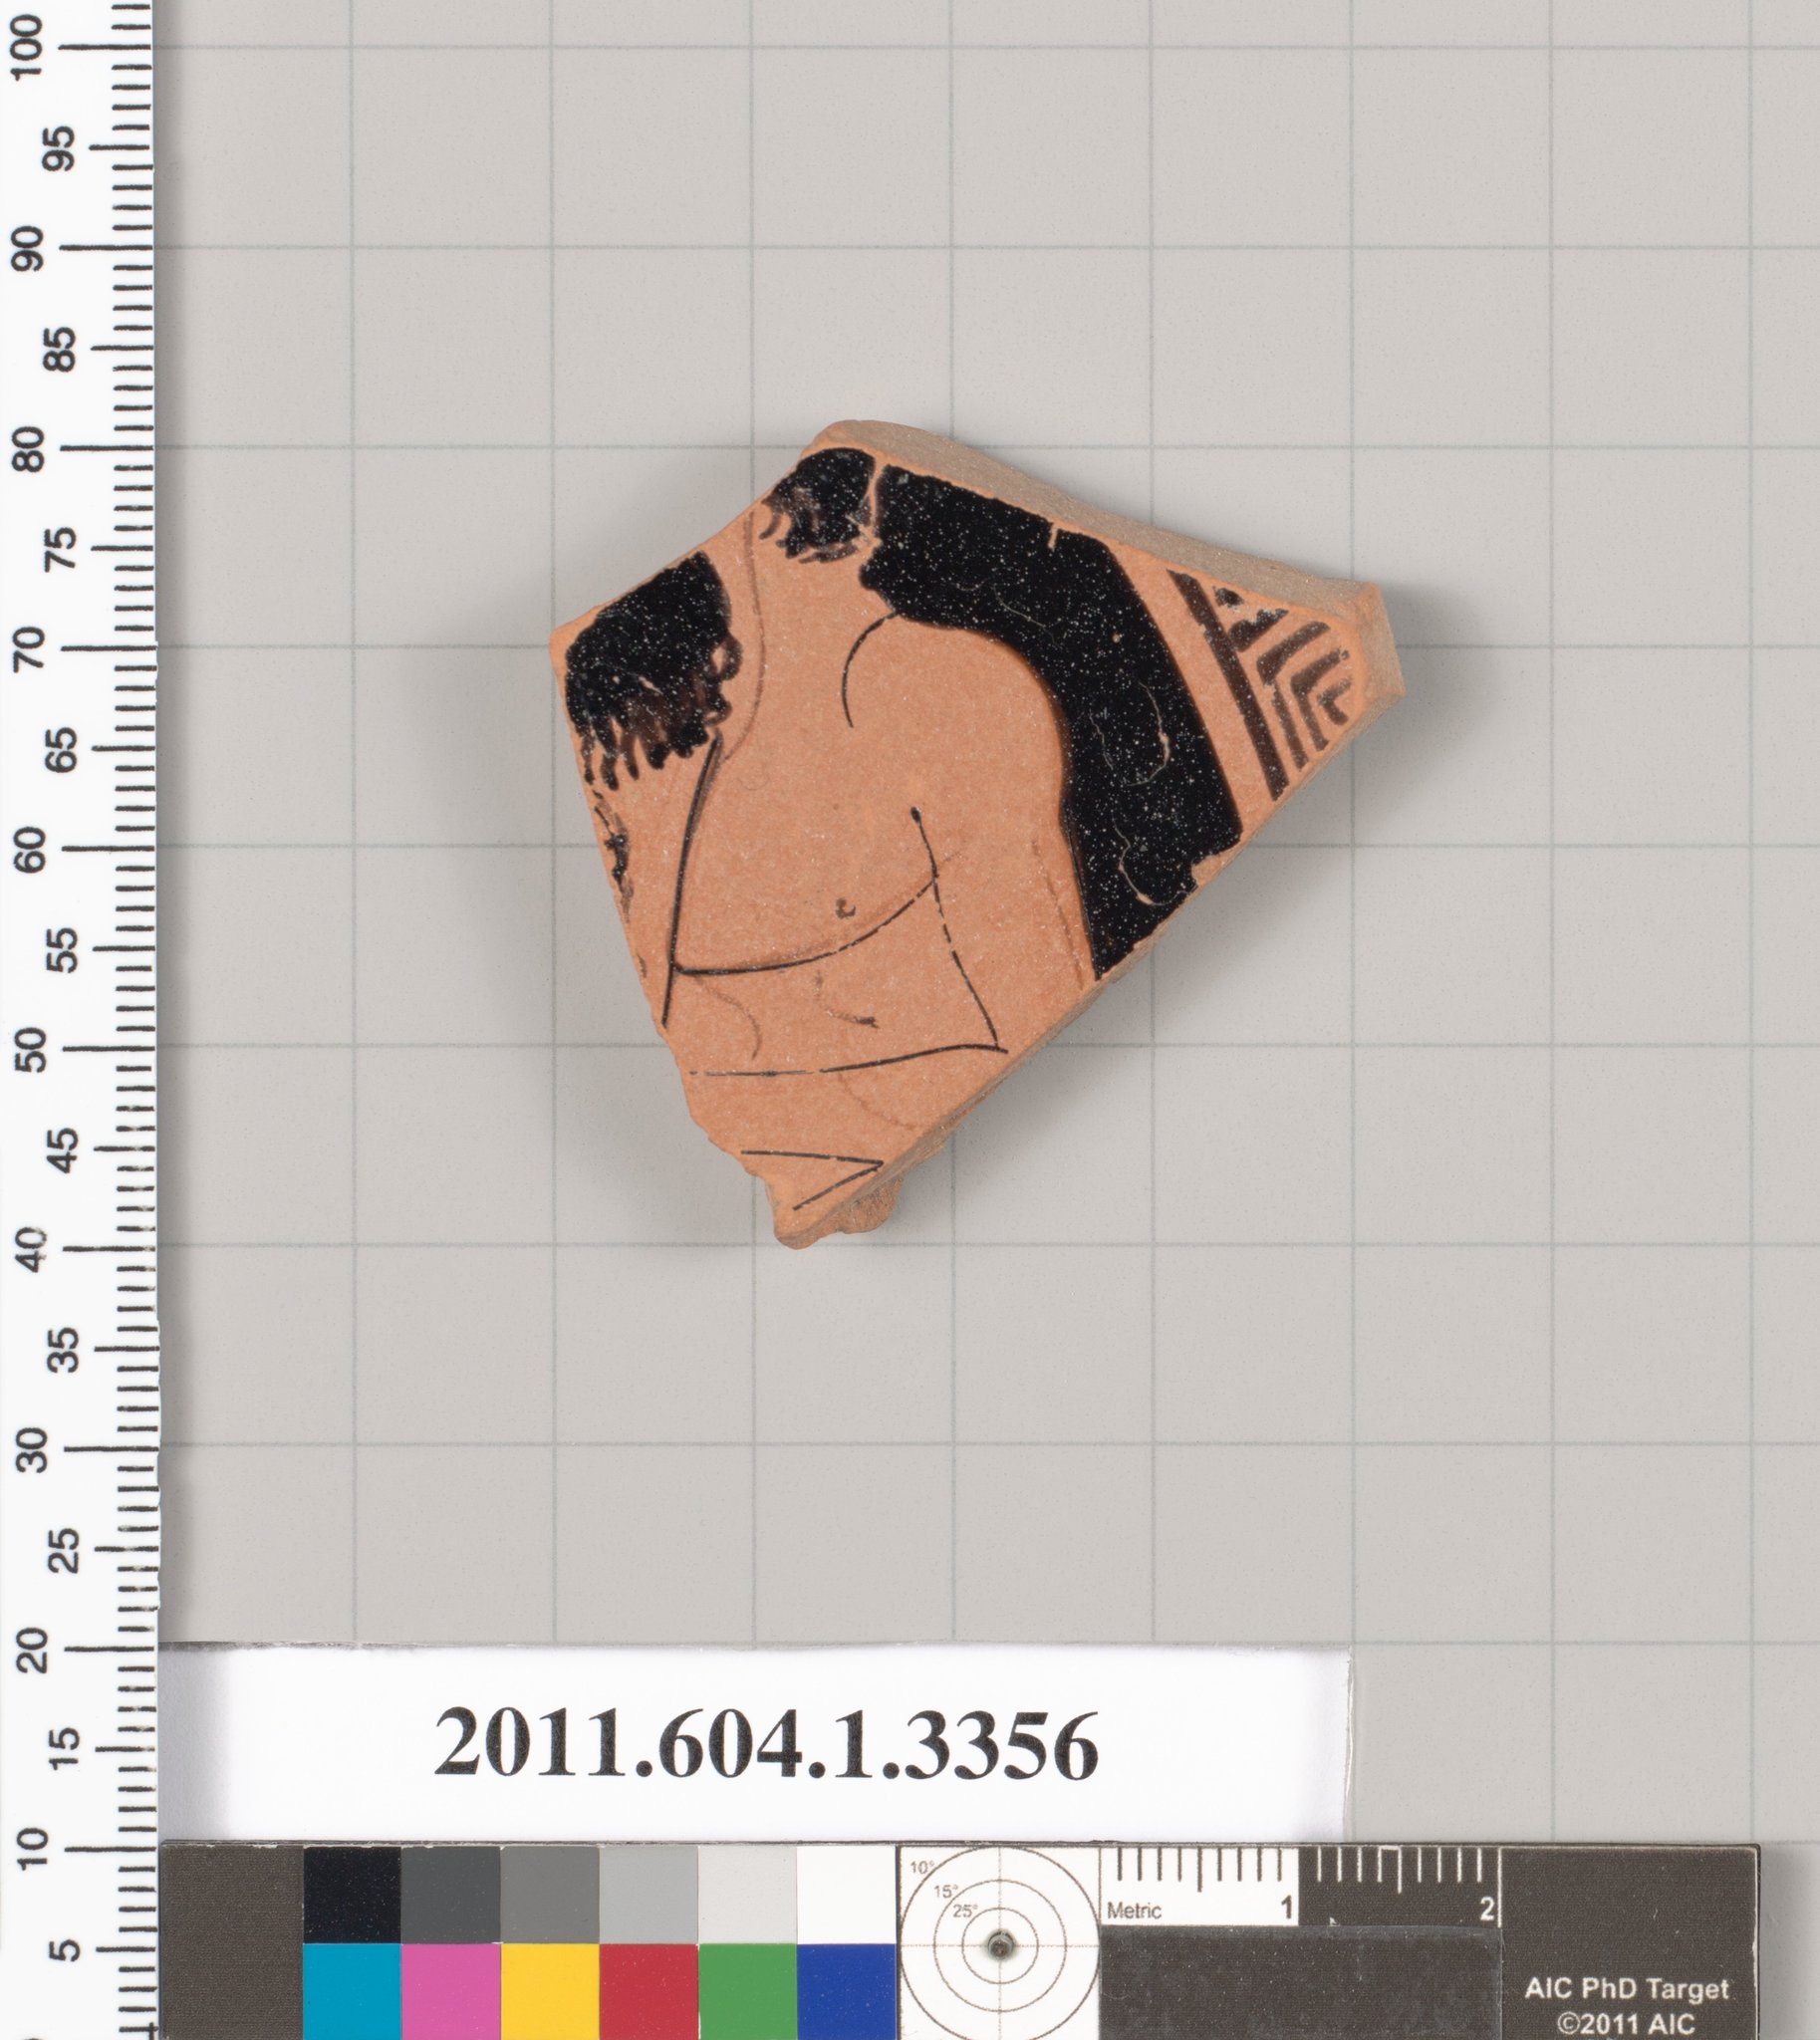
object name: kylix fragment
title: Terracotta fragment of a kylix (drinking cup)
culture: greek, attic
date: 475-451 BCE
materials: terracotta